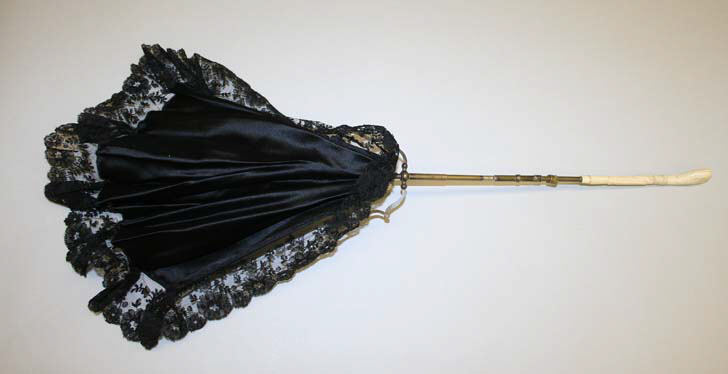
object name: equipment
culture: french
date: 1867-1900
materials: cotton, ivory, metal, silk